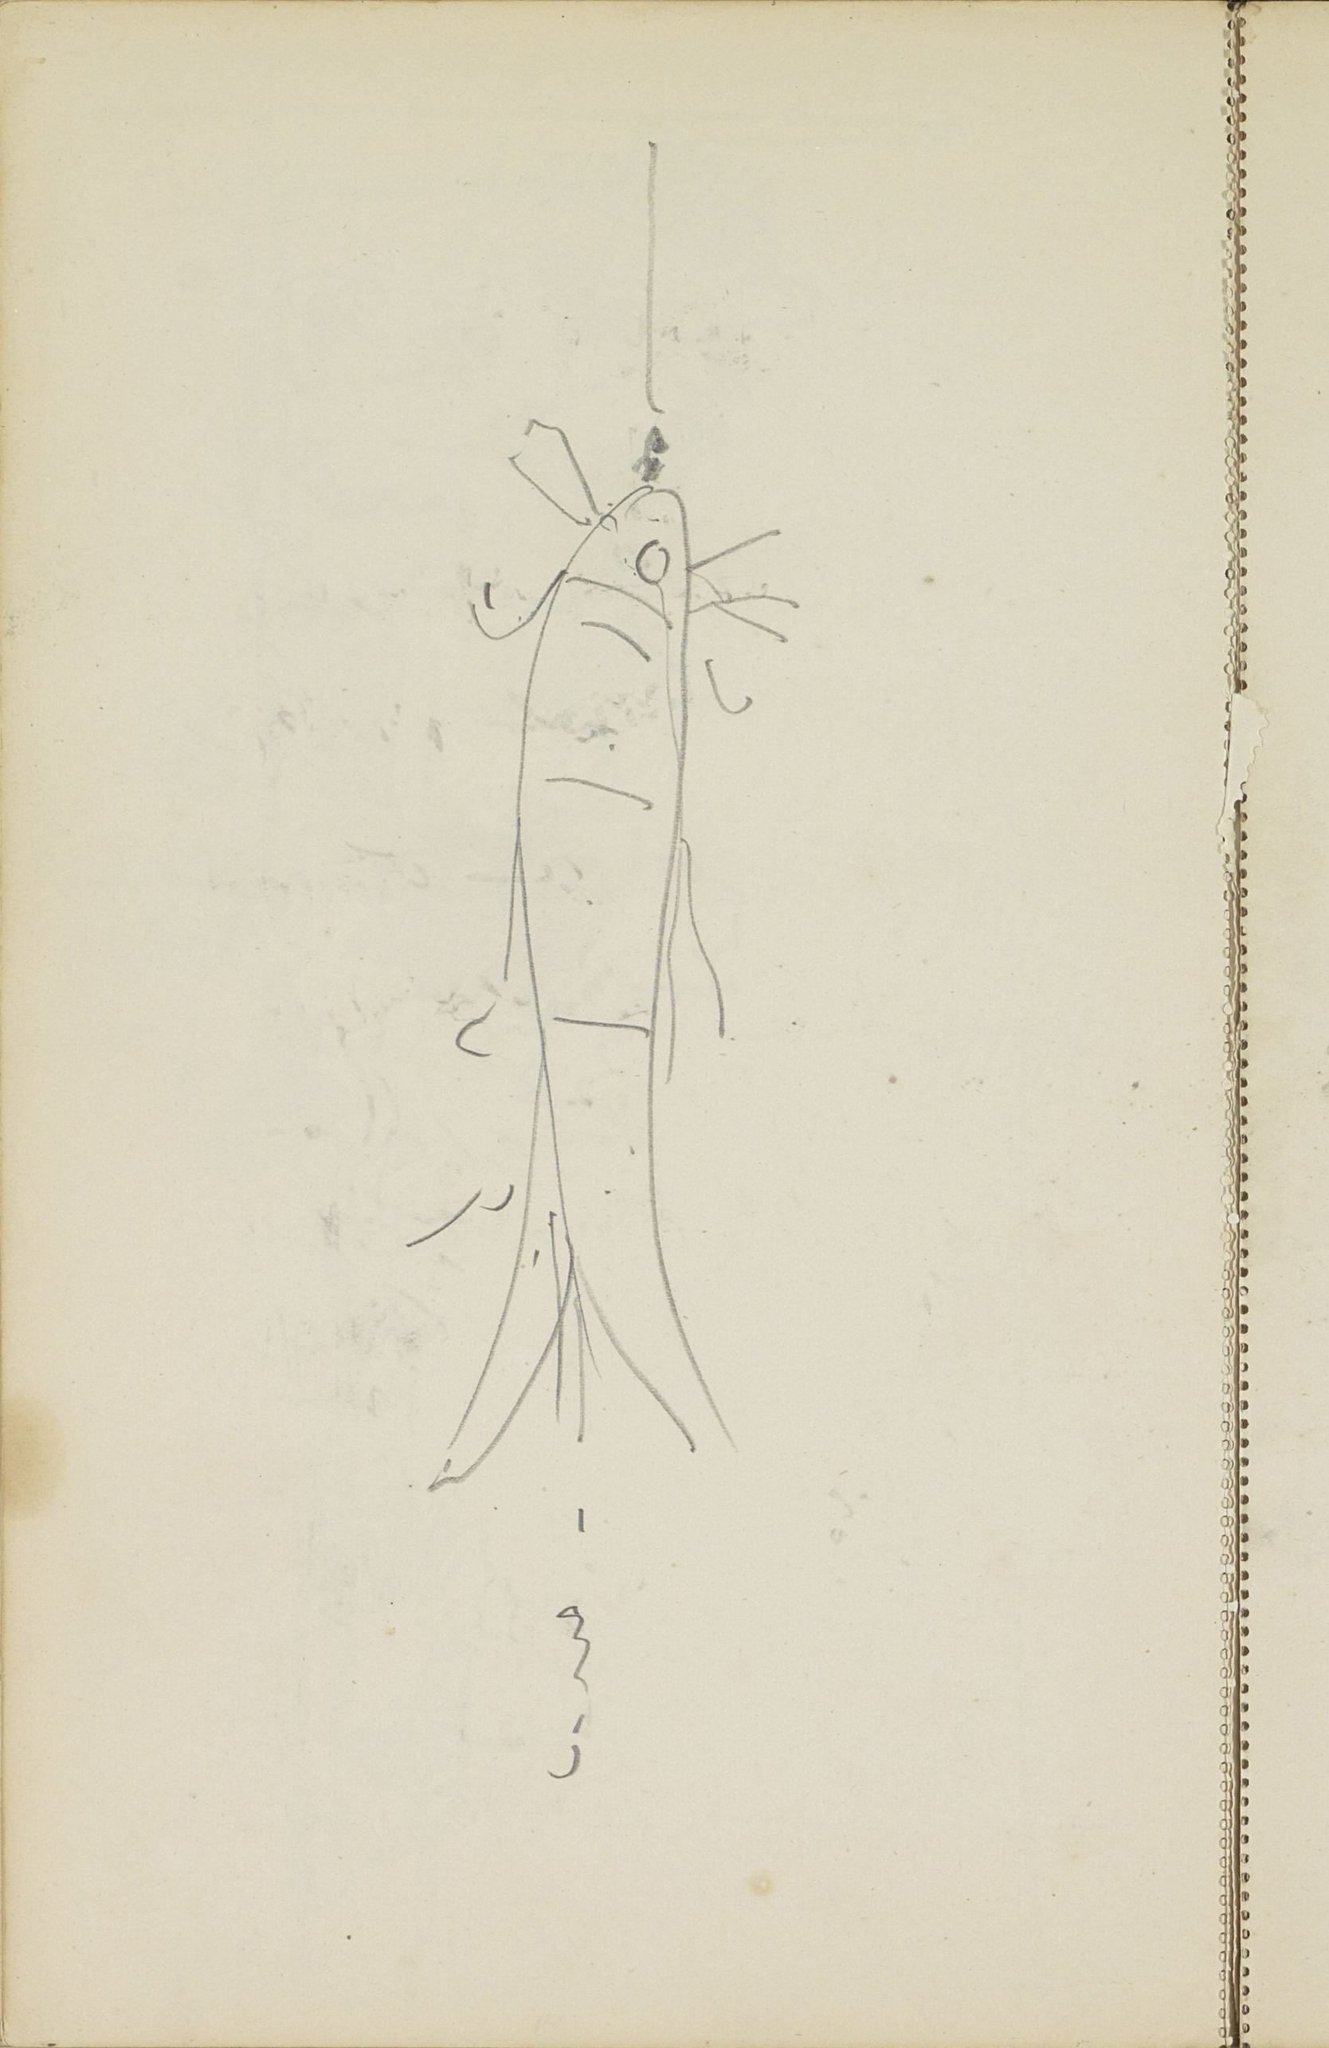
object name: sketchbook leaf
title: Vis aan een haak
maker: cornelis vreedenburgh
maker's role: draughtsman, print maker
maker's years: 1880-1946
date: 1890-1946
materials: paper, pencil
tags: fishes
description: Blad 54 verso uit een schetsboek met 56 bladen.